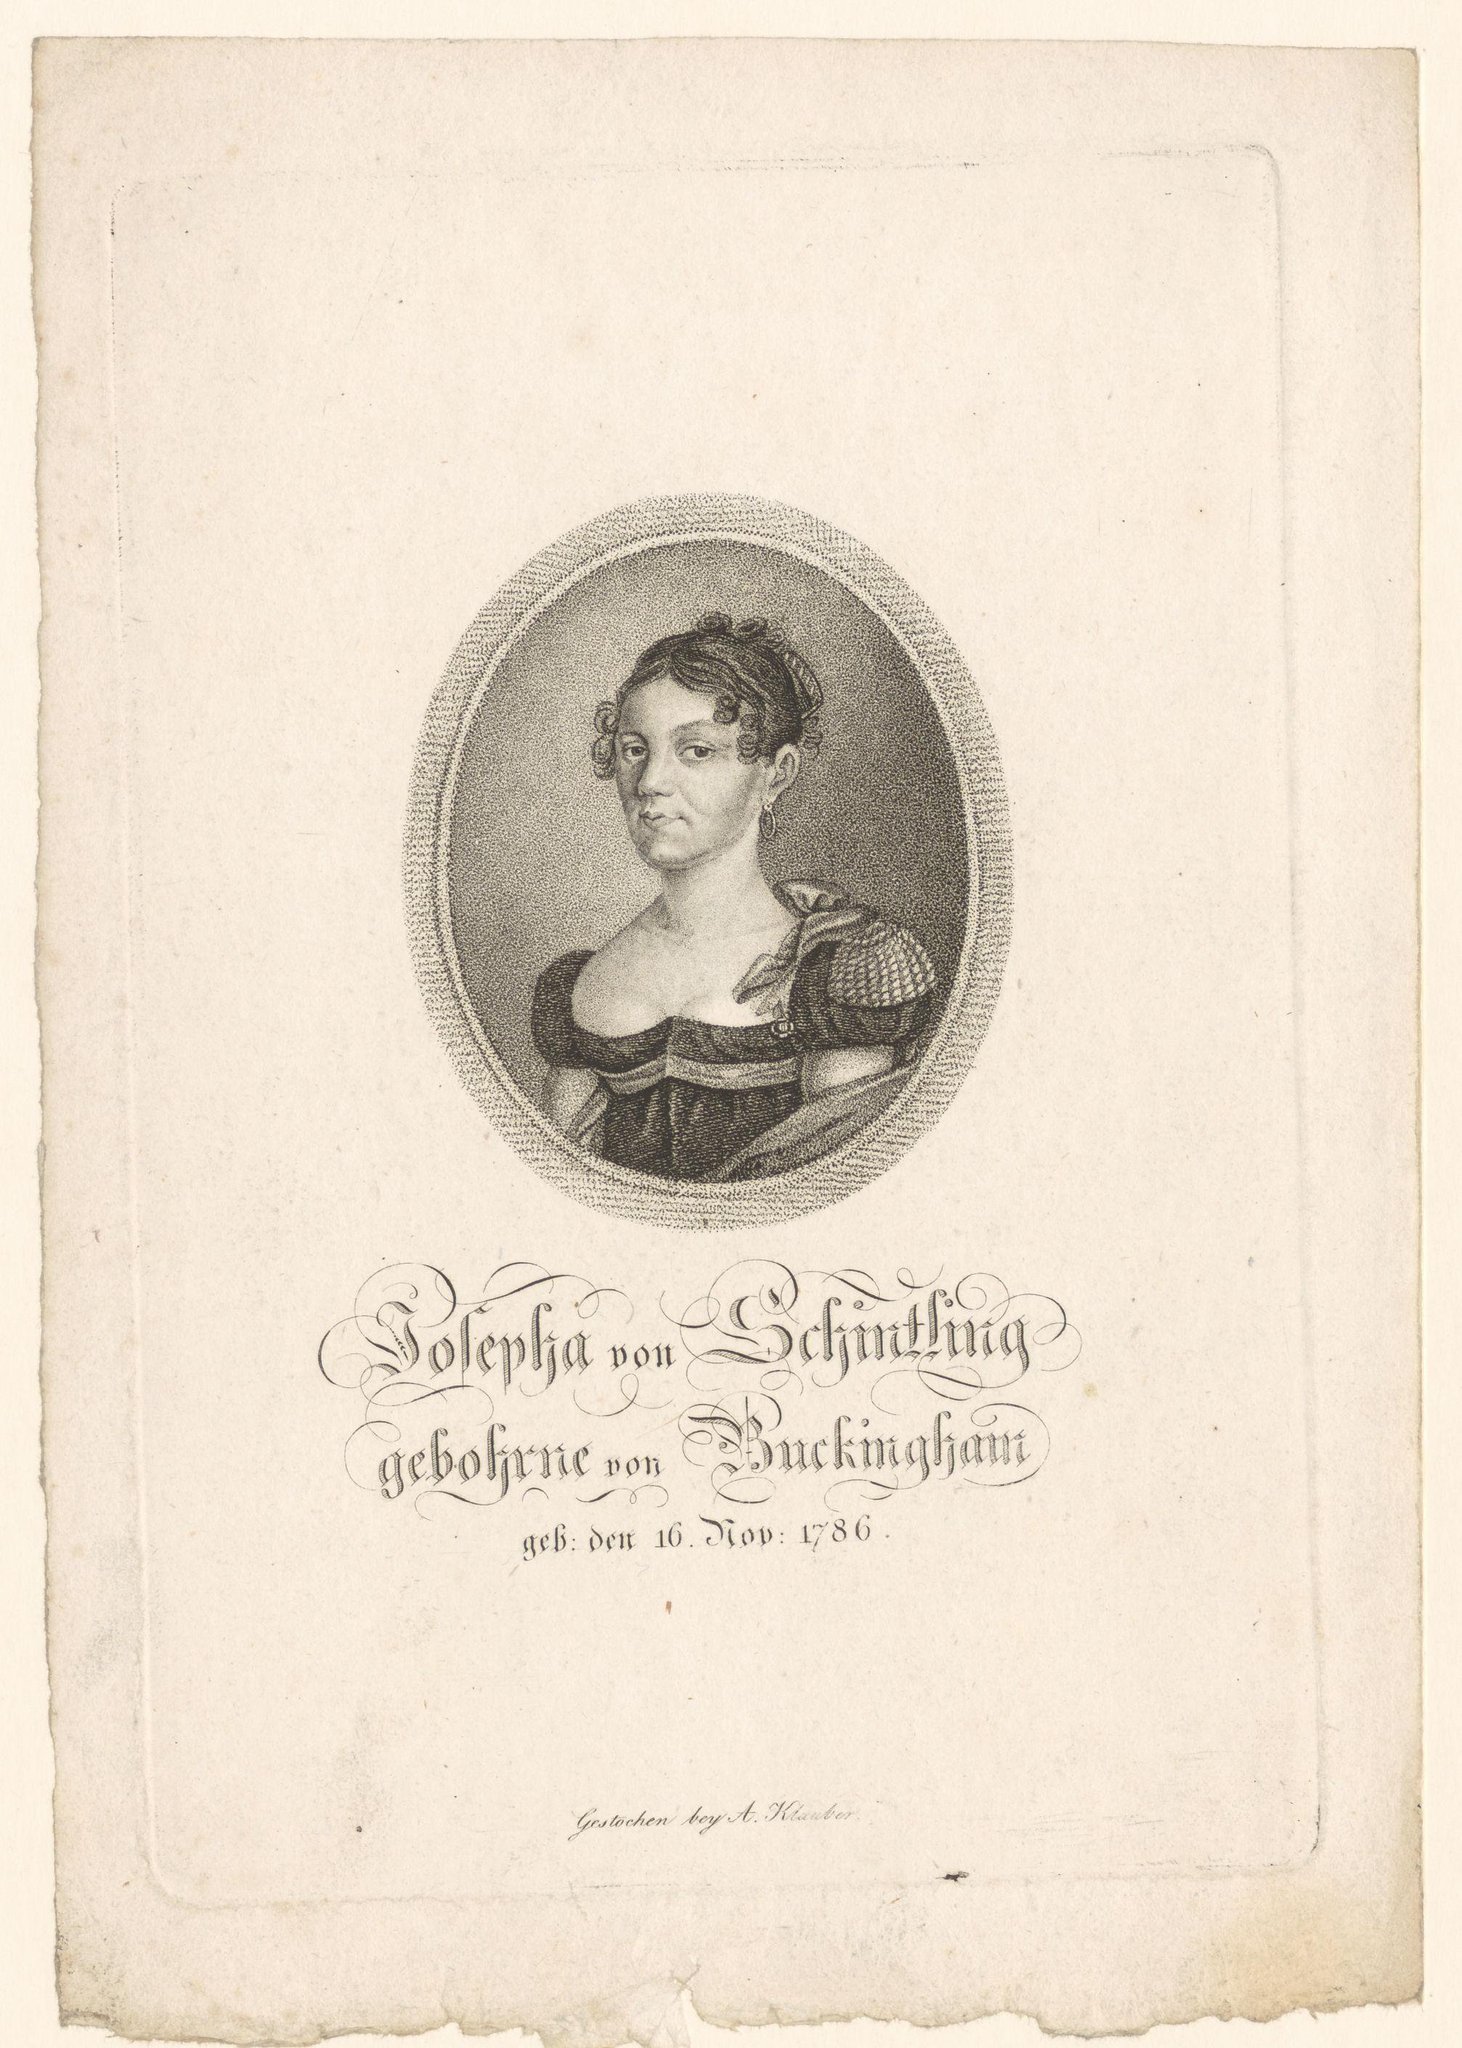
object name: print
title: Portret van Maria Josepha Schintling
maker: joseph anton klauber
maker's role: print maker, publisher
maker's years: 1779-1837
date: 1796-1837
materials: paper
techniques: stippling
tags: historical persons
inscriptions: collector's mark: Lugt 2228